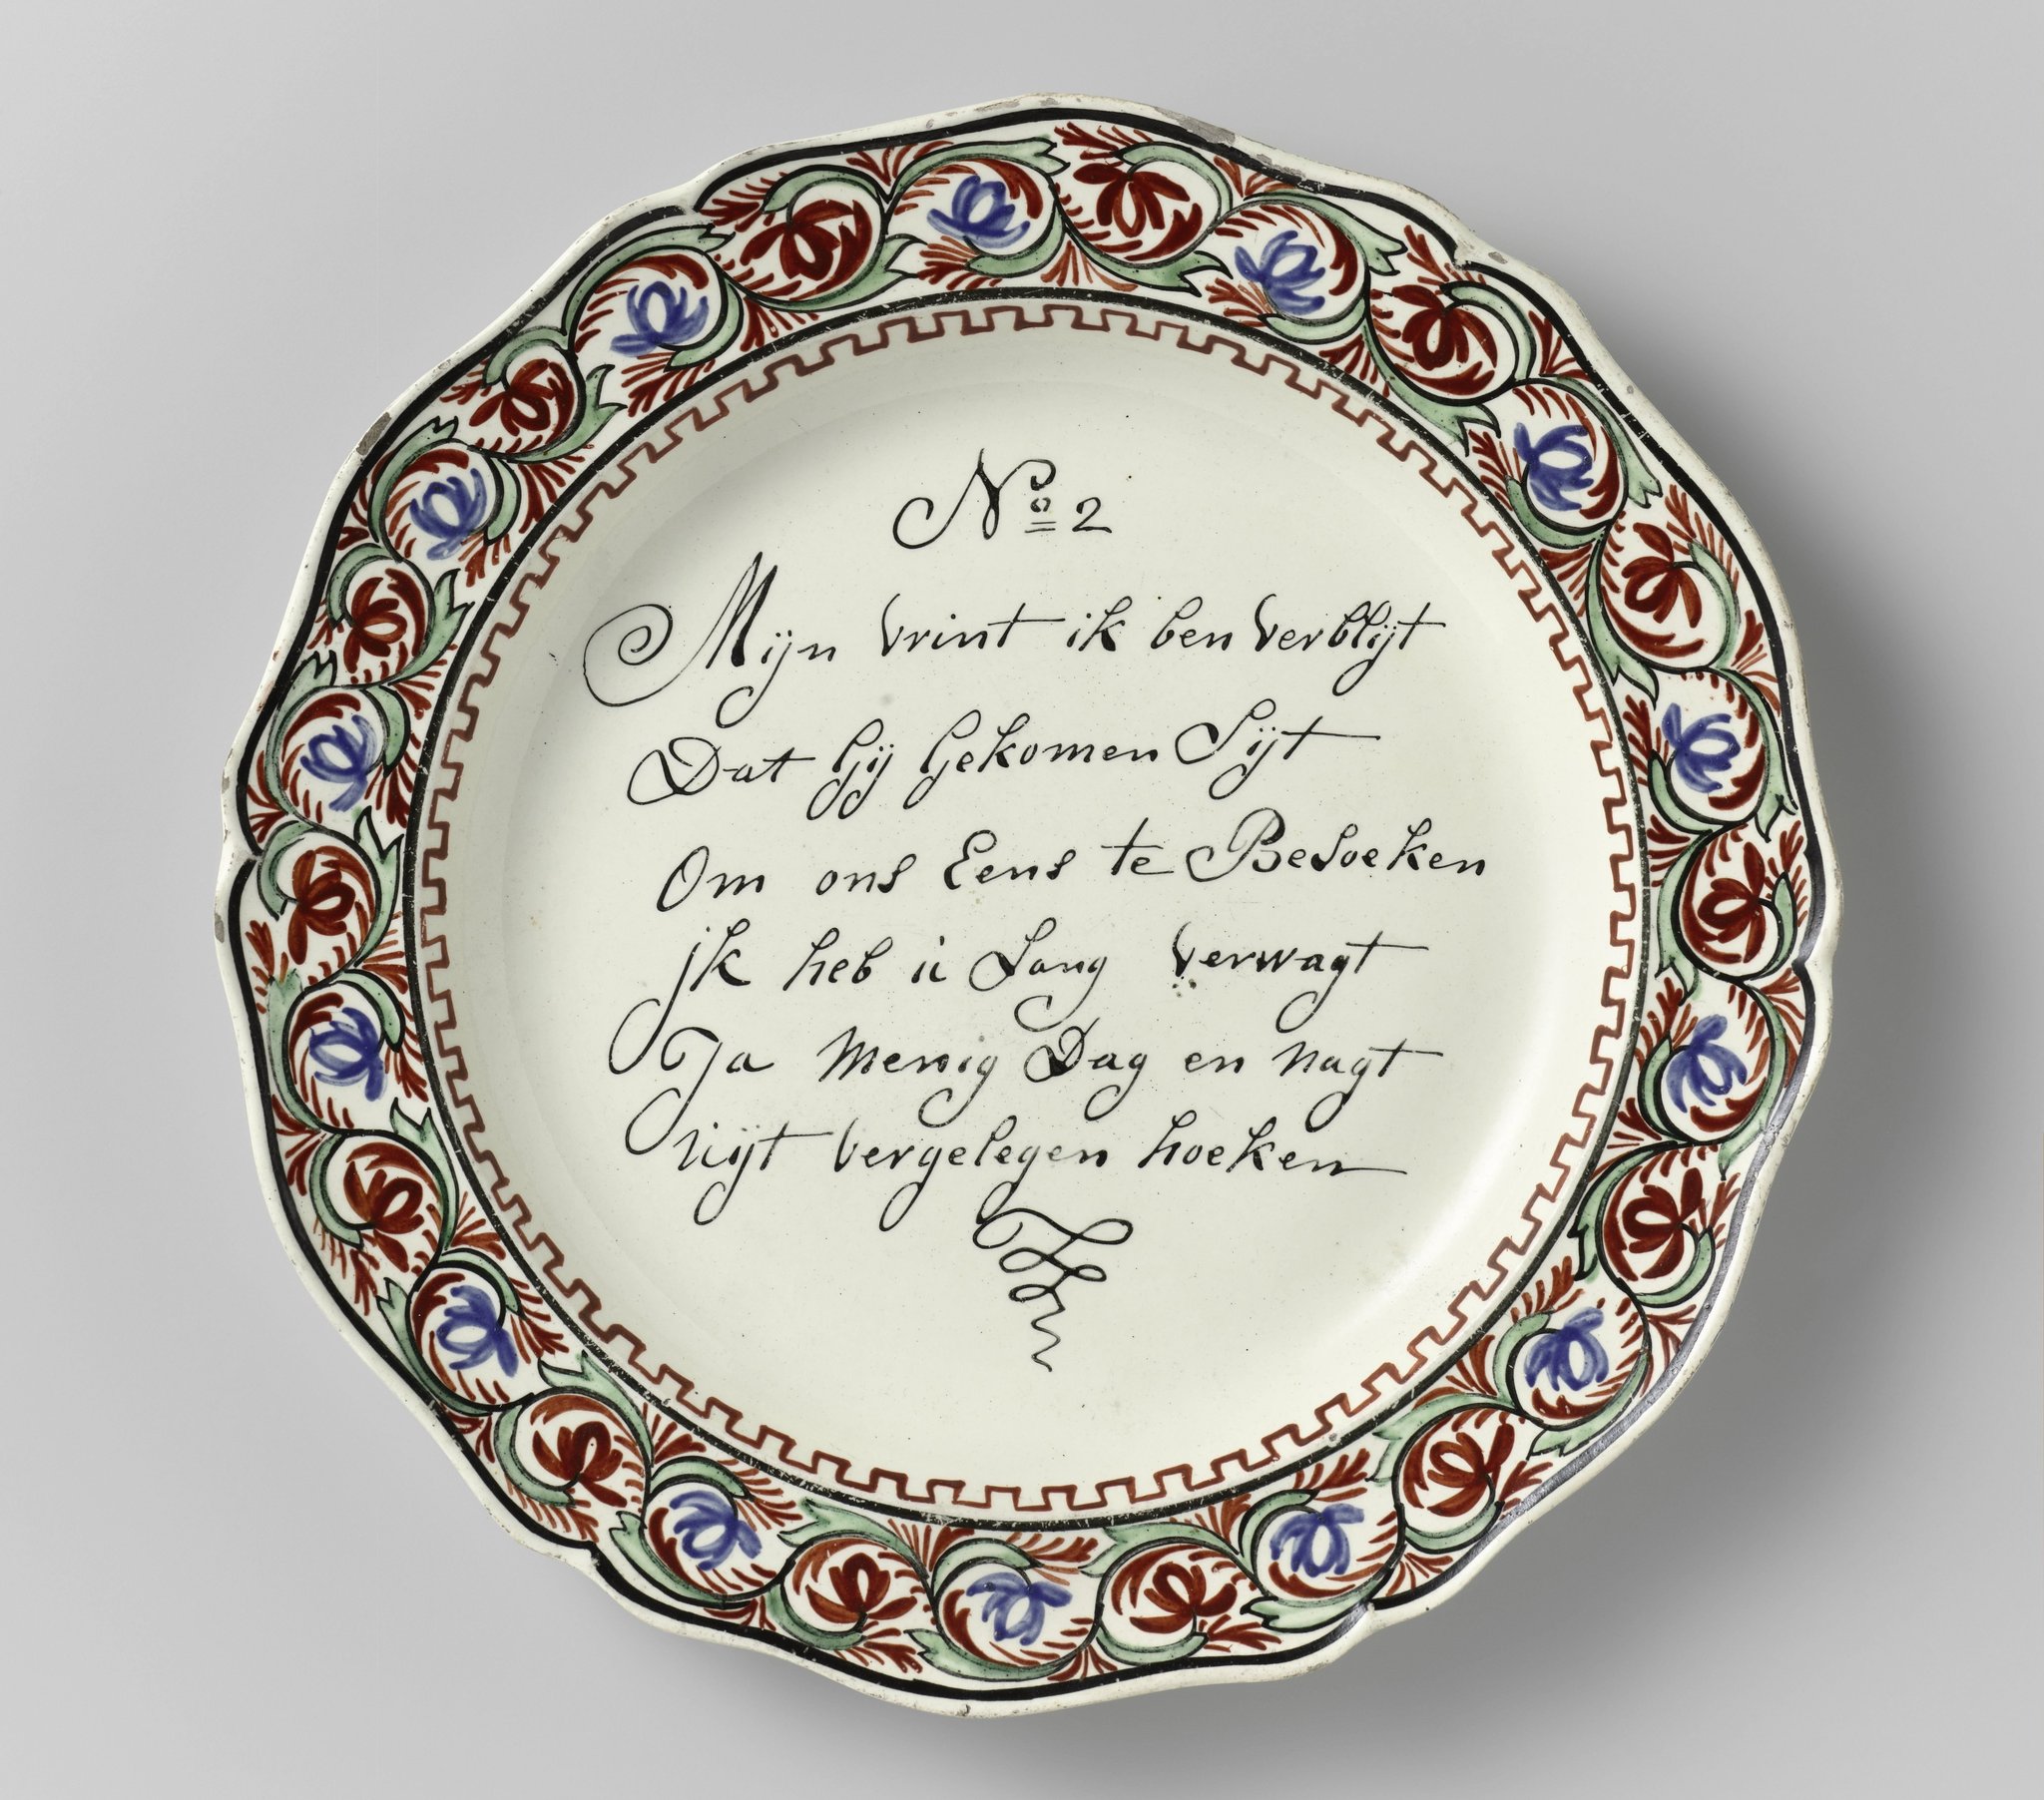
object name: plate dish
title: Rond bord van hardgebakken aardewerk; Liverpool creamware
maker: Anonymous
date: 1780-1800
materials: earthenware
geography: liverpool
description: Rond bord van hardgebakken aardewerk; creamware met decoratie op de glazuur. Op het plat is een Nederlandse tekst geschilderd: No 2 MIJN VRINT IK BEN VERBLIJT...UIJT VERGELEGEN HOEKEN. De rand is beschilderd met een slingerende bladrank. Het bord is gemerkt: HERCULANEUM. Bij het bord hoort een zelfde bord maar met een andere tekst (BK-NM-4394-B).